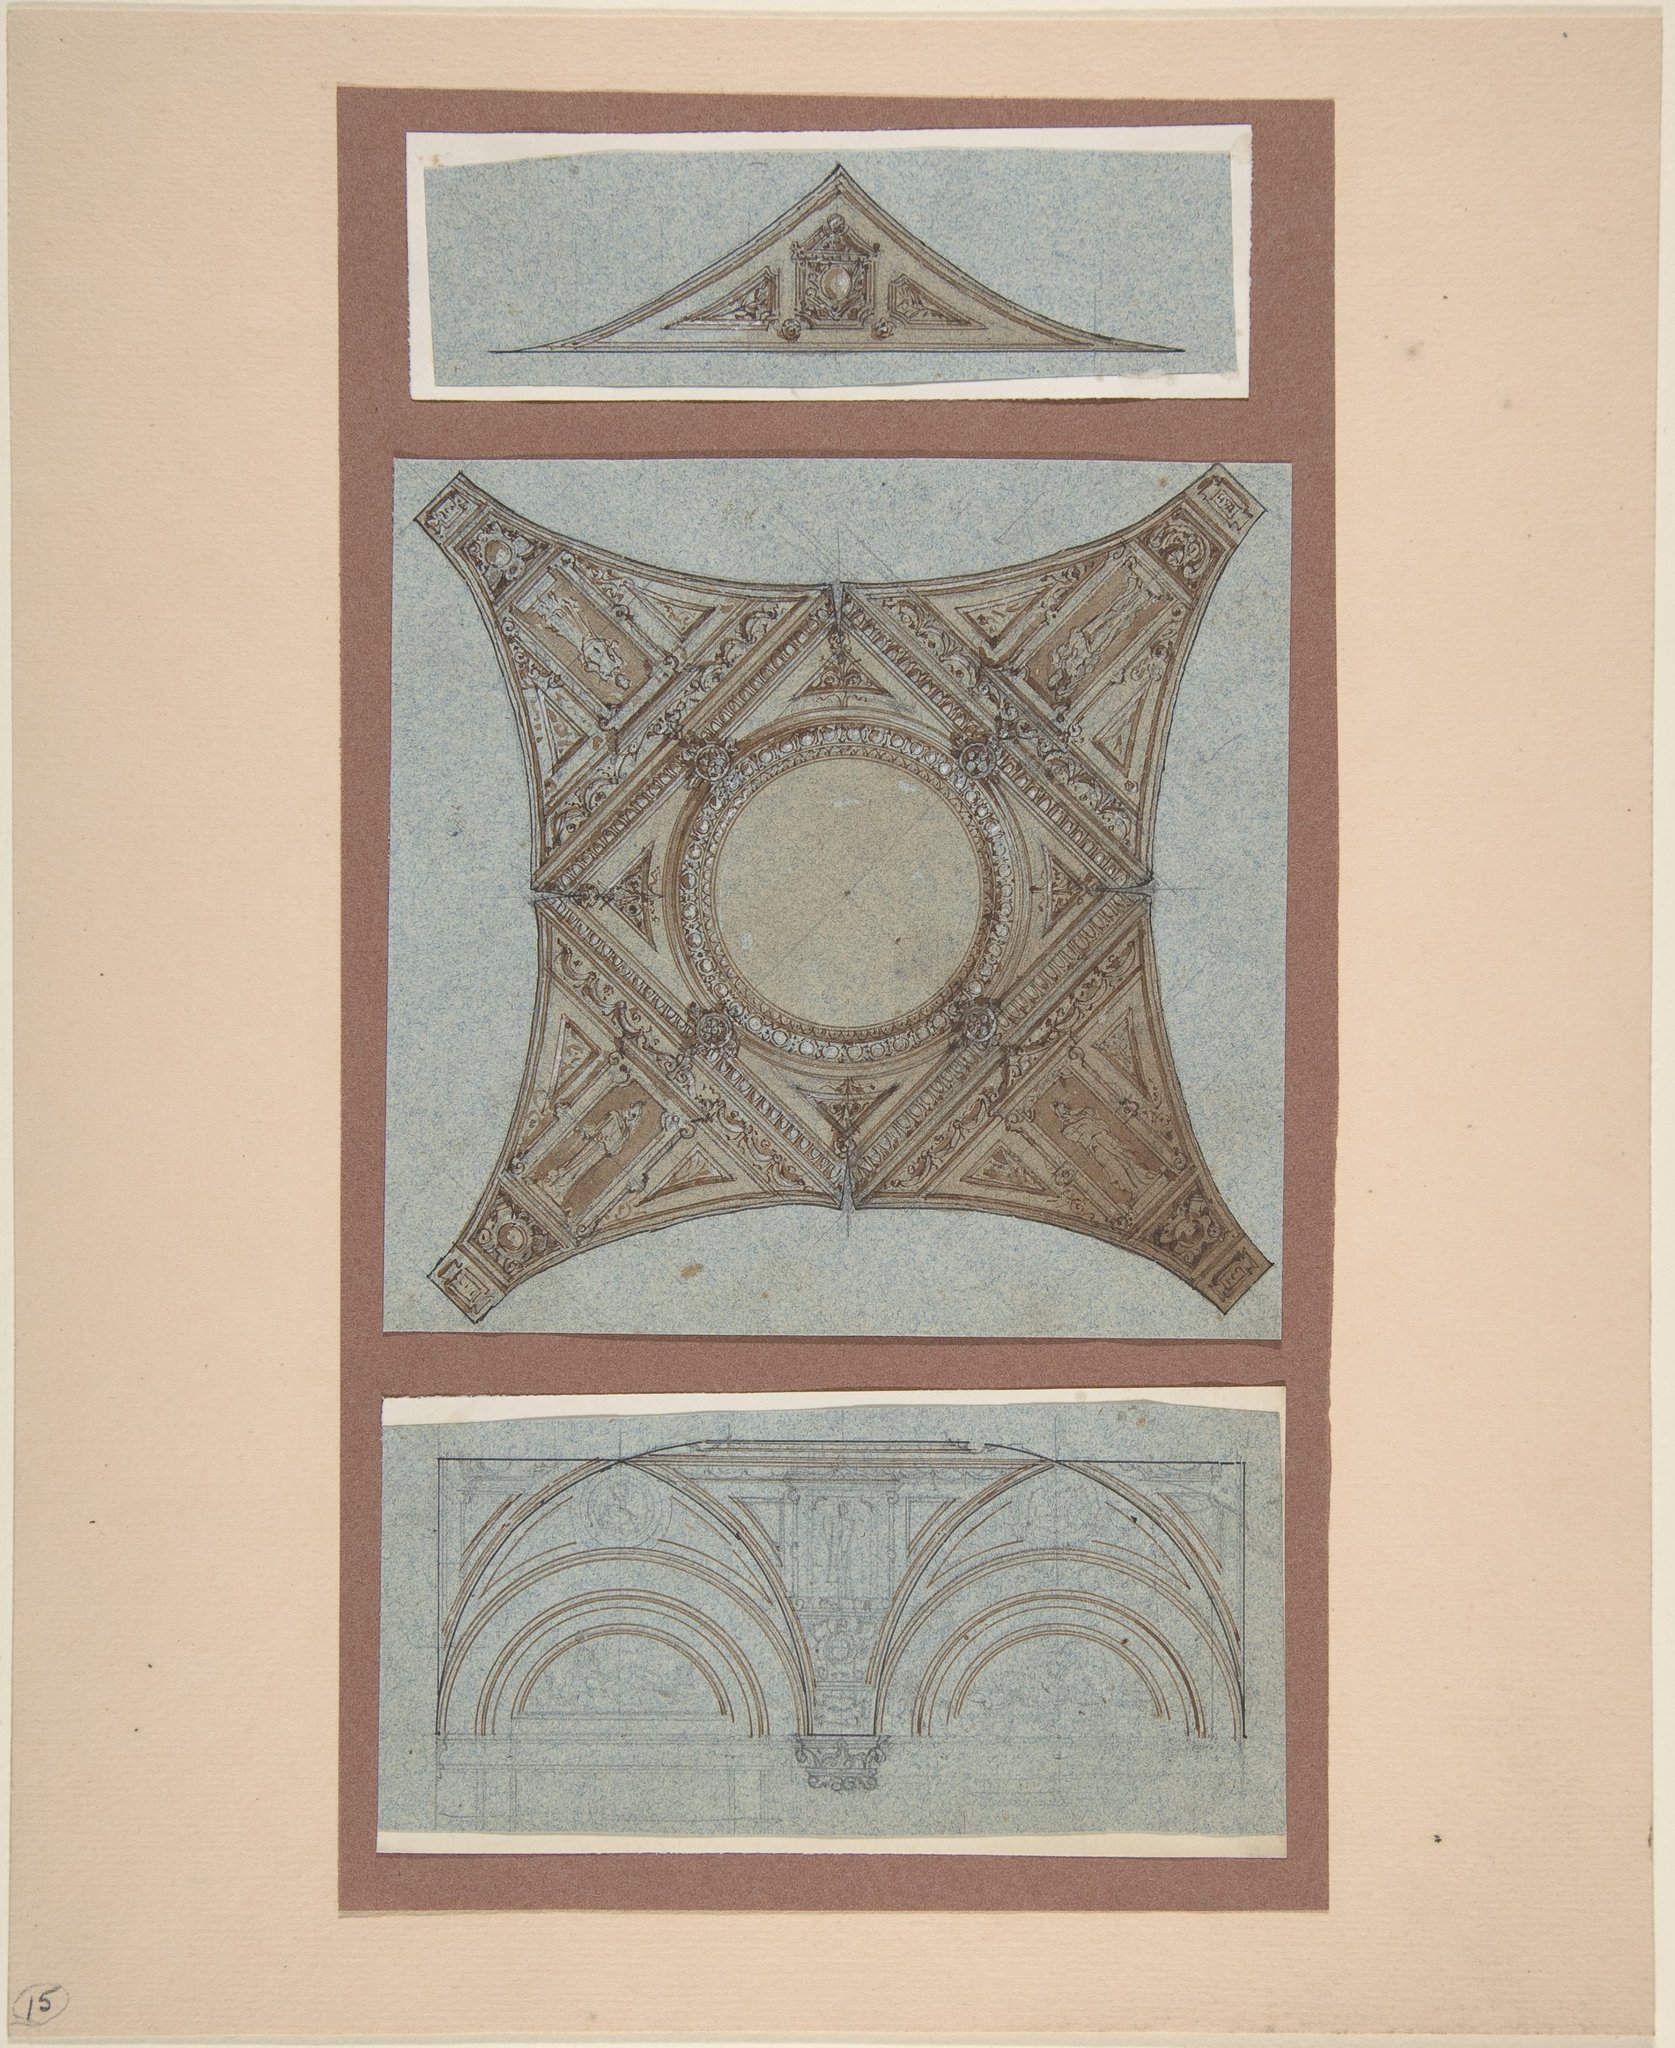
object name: drawing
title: Designs for Decoration of Vaults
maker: anonymous, french, 19th century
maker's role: artist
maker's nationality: french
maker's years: 1800-1900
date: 1870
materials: graphite, ink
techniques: brush, pen, wash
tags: architecture